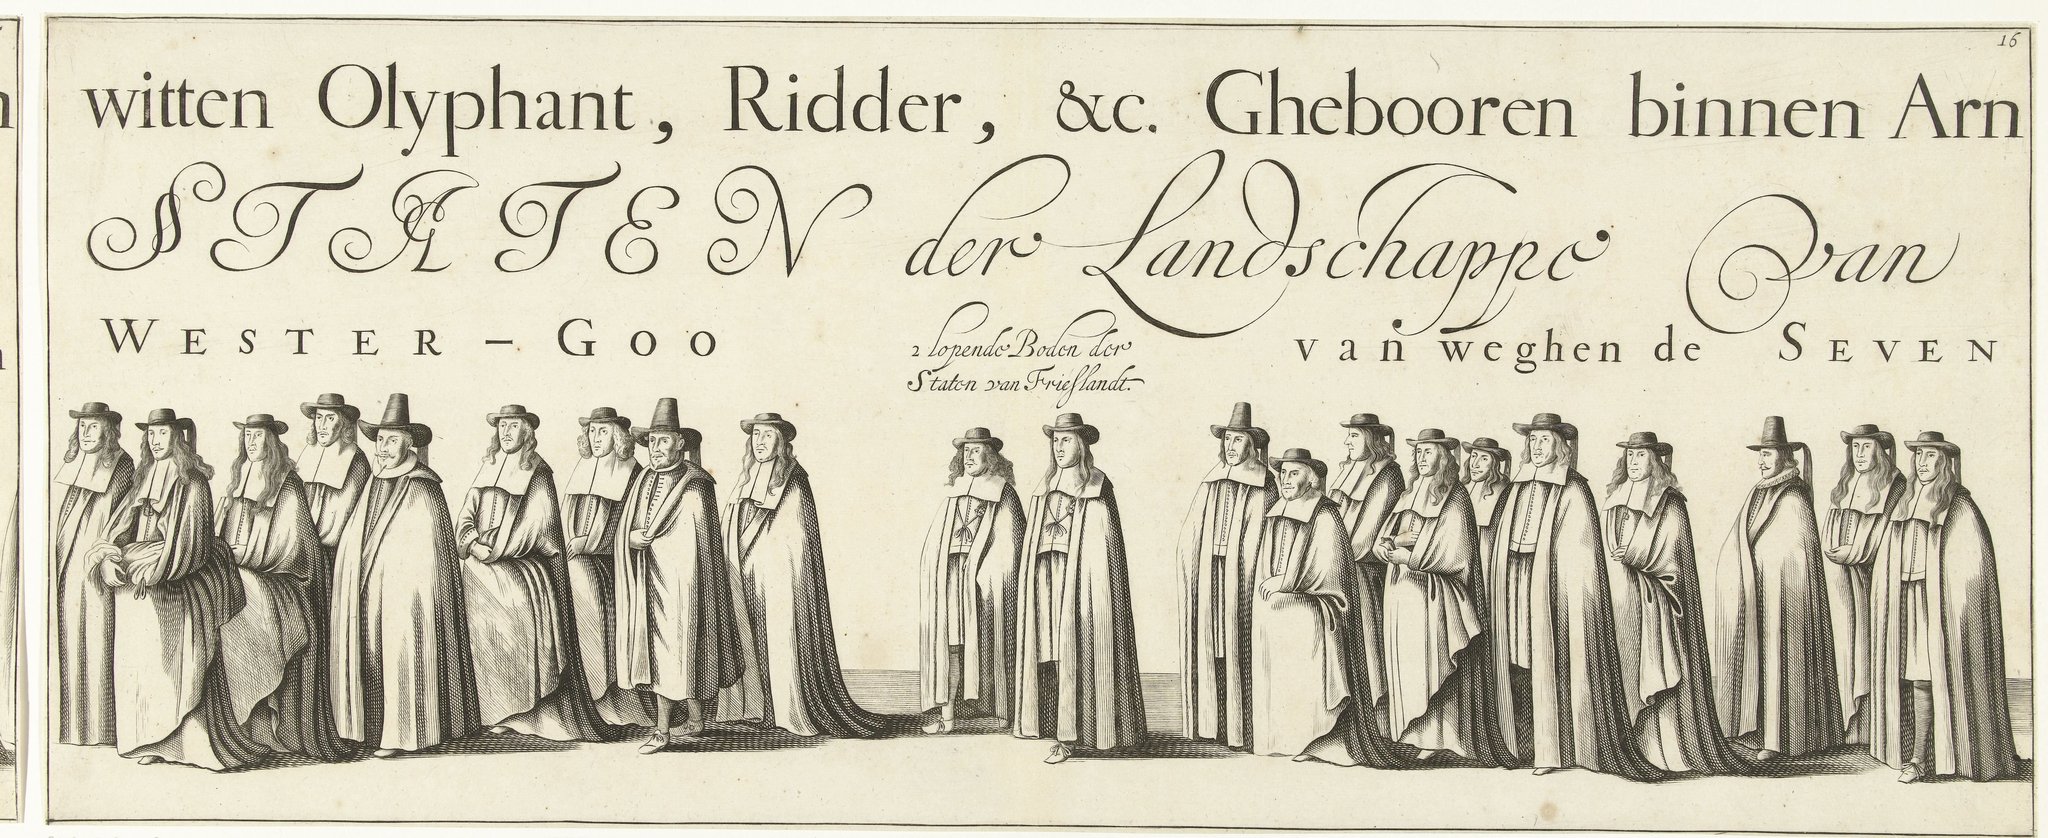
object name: print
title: Rouw-Staetelijcke Lijk-pracht in de Uyt-Vaert en Begraefenisse van het ont-zielde Lichaem van (...) Wilhelm Frederich (...) Overleden binnen Leeuwarden (...) den een-en-twintichsten October, MDCLXIV. en aldaer in 't Choor van de Jacobijner Kerck, den vyfthienden december MDCLXIV. Oude Stijl (...)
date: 1666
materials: paper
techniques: engraving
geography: leeuwarden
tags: arnhem, cortege, funeral procession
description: Begrafenisoptocht van Willem Frederik, graaf van Nassau-Dietz, in Leeuwarden op 6 januari 1665. Deel van de begrafenisstoet. Plaat nr. 16 in een ensemble van 24 (van de 25) ongemonteerde genummerde platen (zonder tekstbladen) die samen een lange fries vormen.